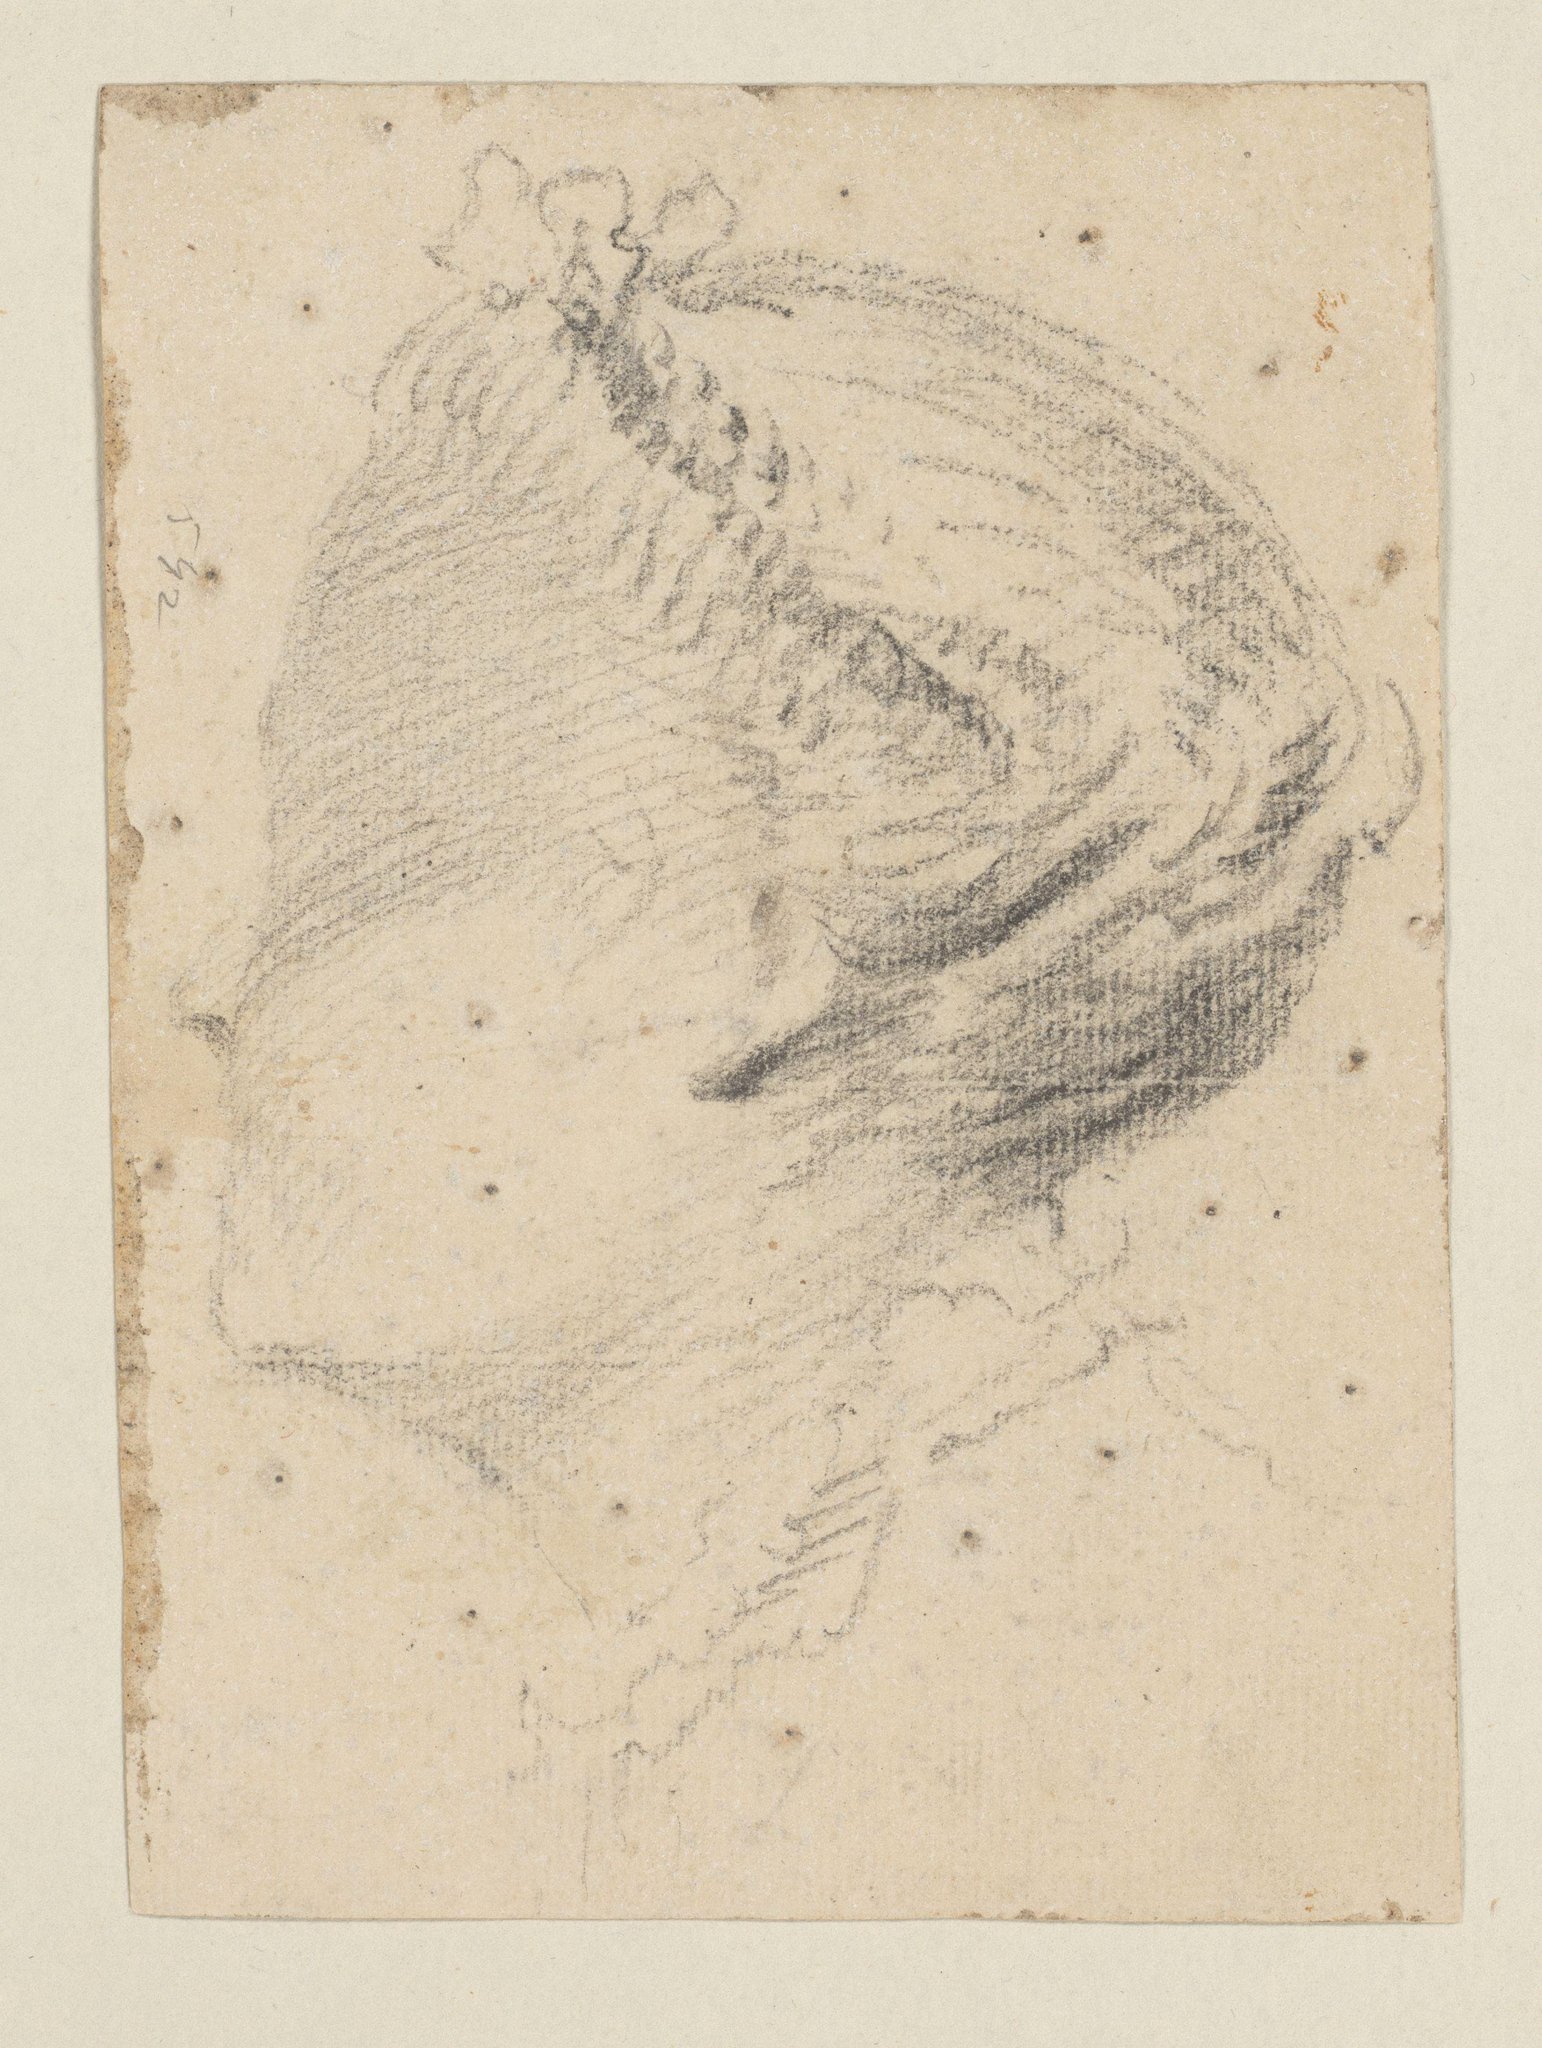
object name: drawing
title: Buste van een vrouw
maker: cornelis ploos van amstel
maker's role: draughtsman, print maker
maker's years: 1726-1798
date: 1736-1798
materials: chalk, lacquer, paper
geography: amsterdam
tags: chest, bust - aa - female human figure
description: De tekening ligt los achterin een album.